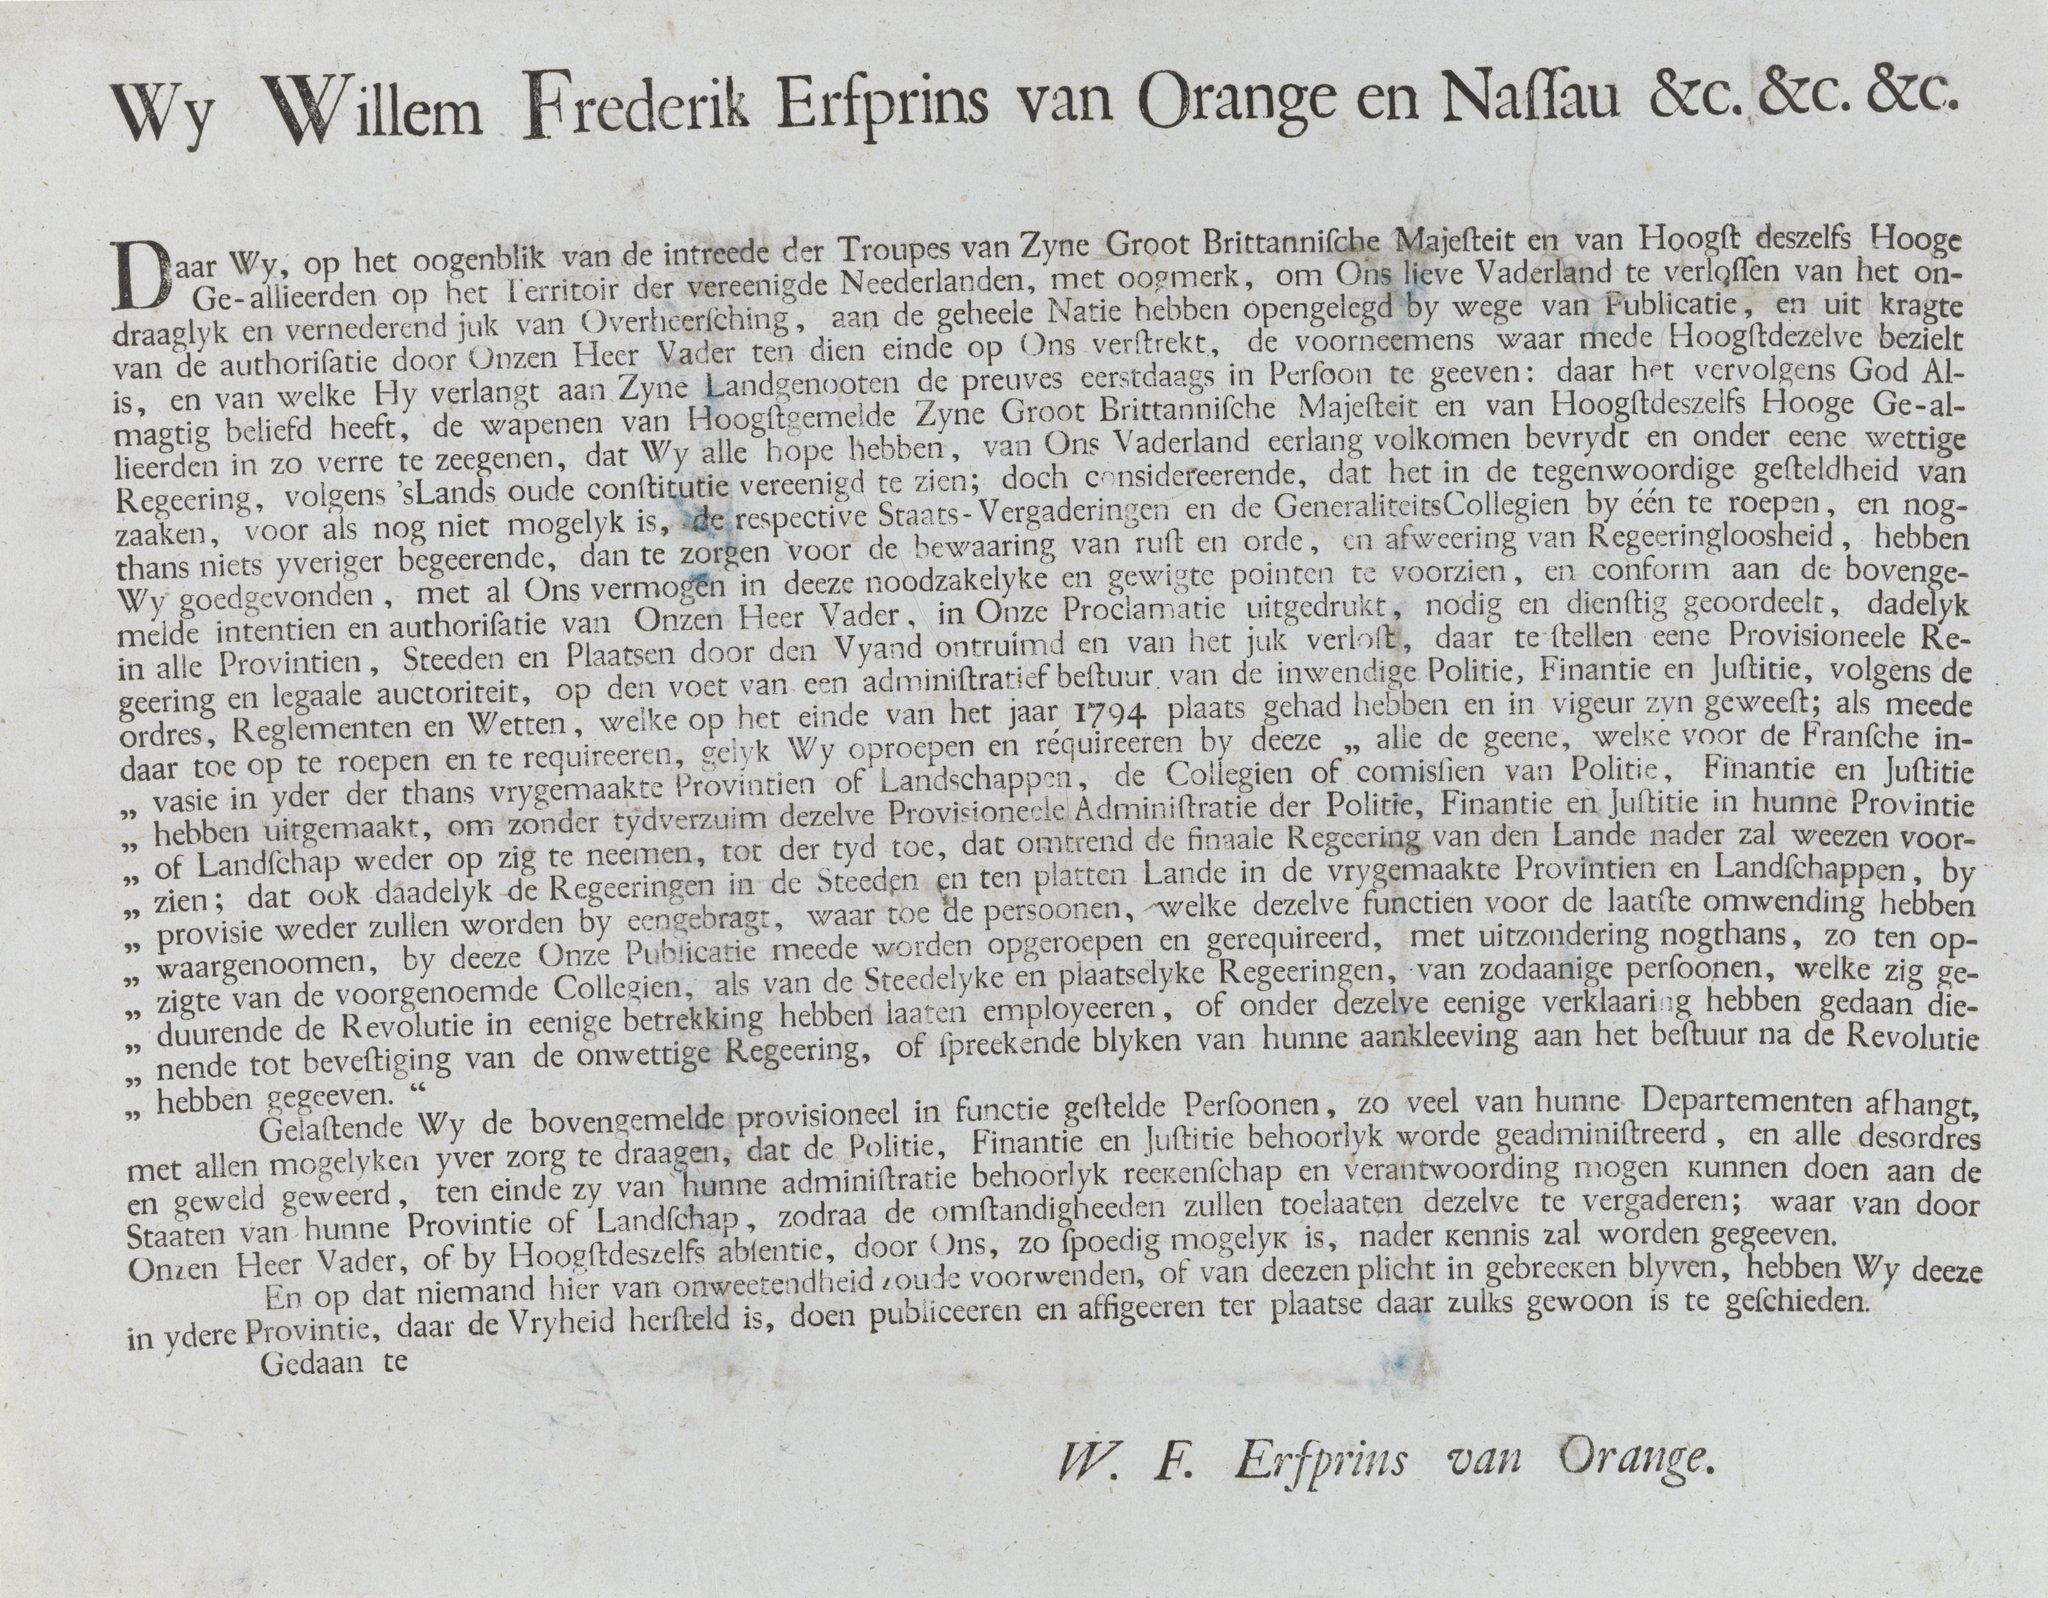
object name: proclamation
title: Wy Willem Frederik Erfprins van Orange en Nassau (...)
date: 1708-1799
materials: paper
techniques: letterpress printing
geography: germany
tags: the hague, berlin, william i of the netherlands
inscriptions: collector's mark: Lugt 2228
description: Tekstblad met een proclamatie van erfprins Willem bij de landing van Britse troepen in de Nederlanden, augustus 1799.